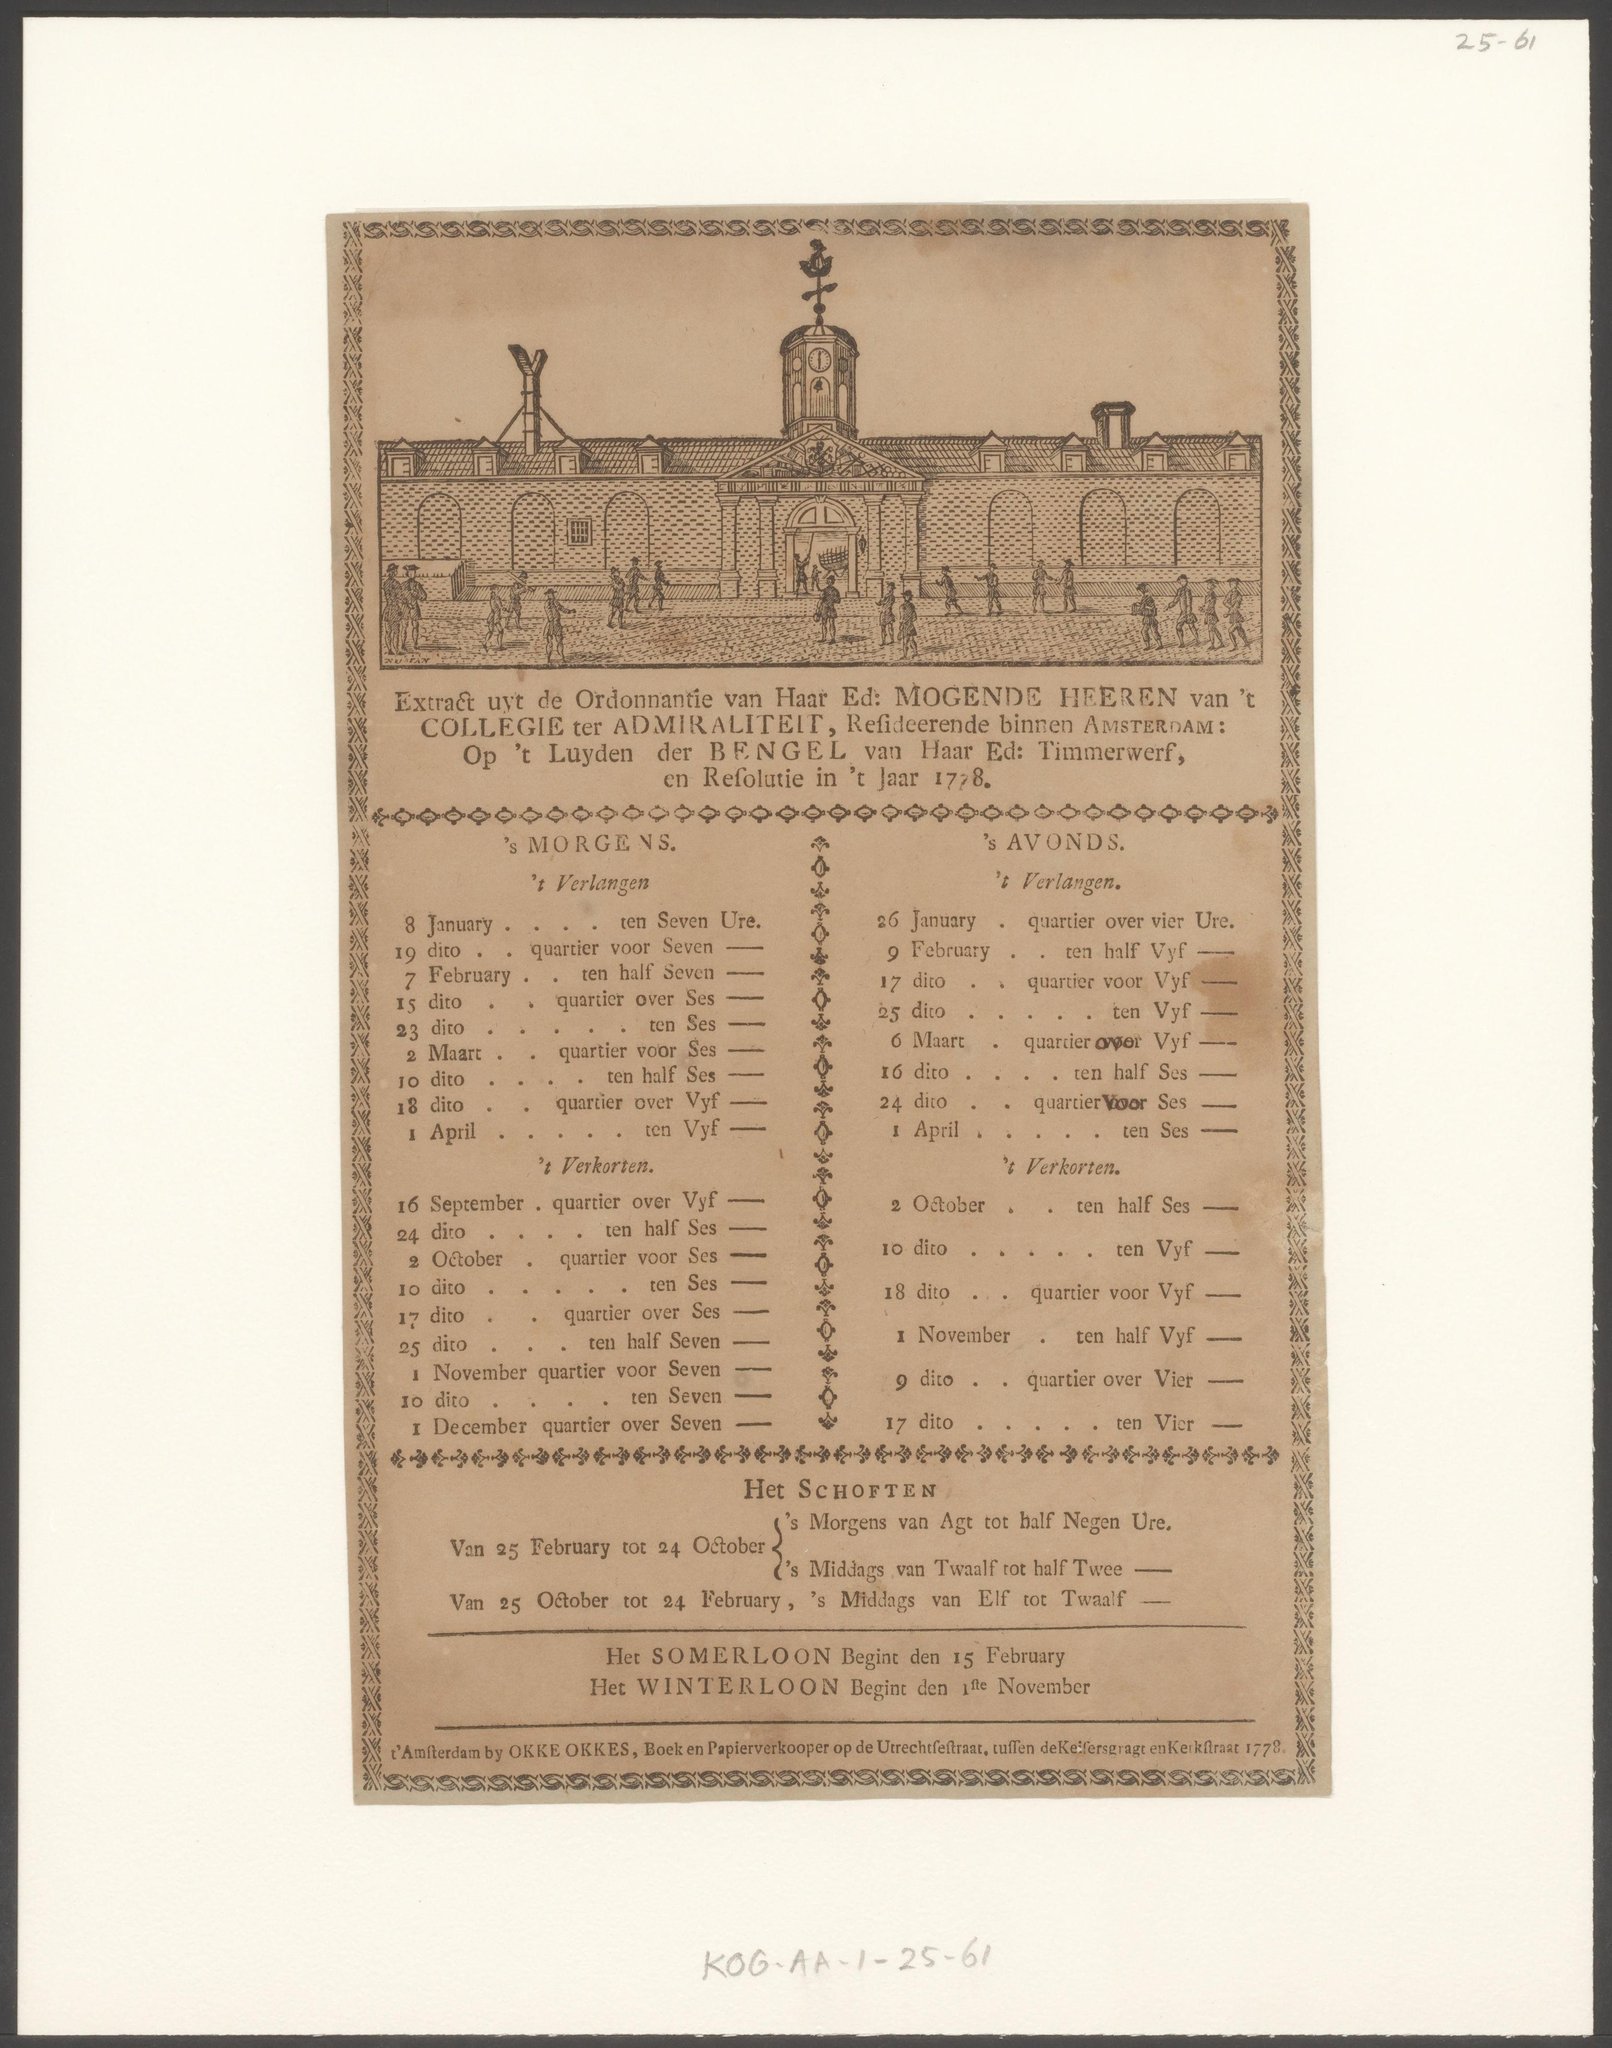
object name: document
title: Werk- en schafttijden op de Admiraliteitswerf te Amsterdam in 1778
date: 1778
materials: paper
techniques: letterpress printing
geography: amsterdam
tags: paying of wages, ship's carpenter, façade (of house or building)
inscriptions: signature: ‘NUMAN’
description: Onderwerpsrubriek binnen de Atlas Amsterdam: Krijgswezen I: De Admiraliteit van Amsterdam, A. Admiraliteitsgebouwen.